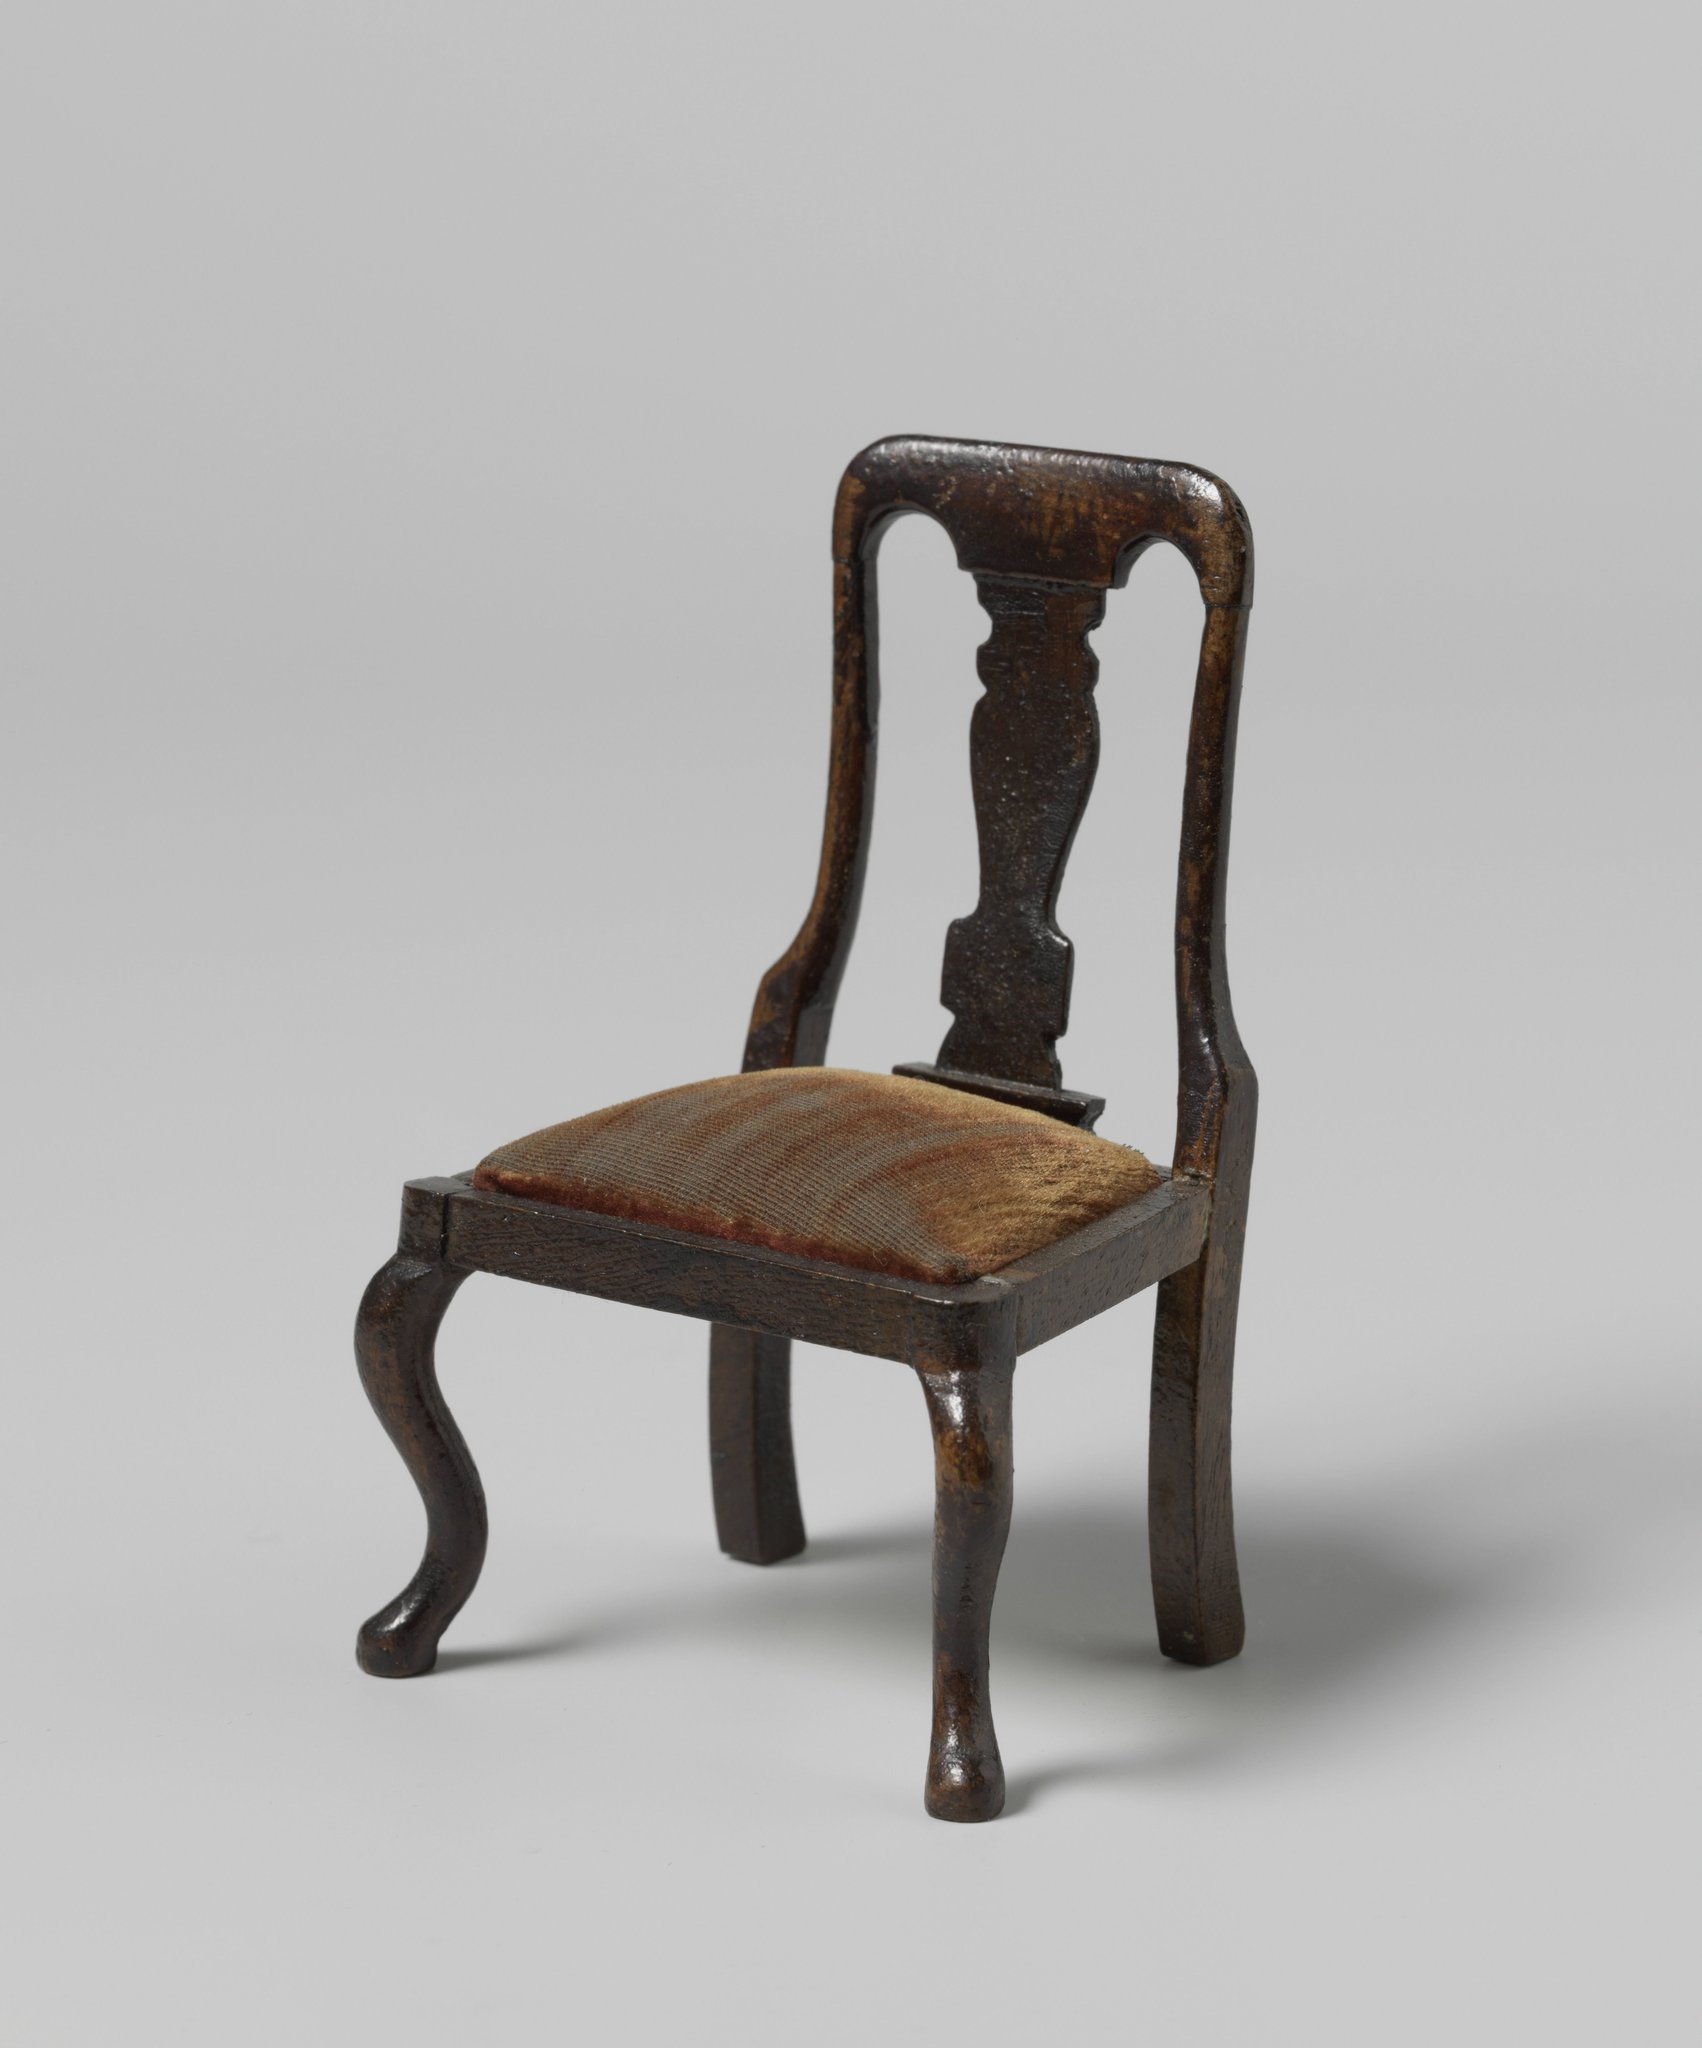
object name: miniature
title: Stoel, de rug met vaasvormig middenblad, de zitting met bordeauxrode fluweel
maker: Anonymous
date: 1800-1899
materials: wood, velvet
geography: amsterdam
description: Stoel van mahoniehout. De rug is open met een vaasvormig middenblad. De stoel heeft een trapezium-vormig open zitraam met losse zitting met bordeauxrode fluweel.